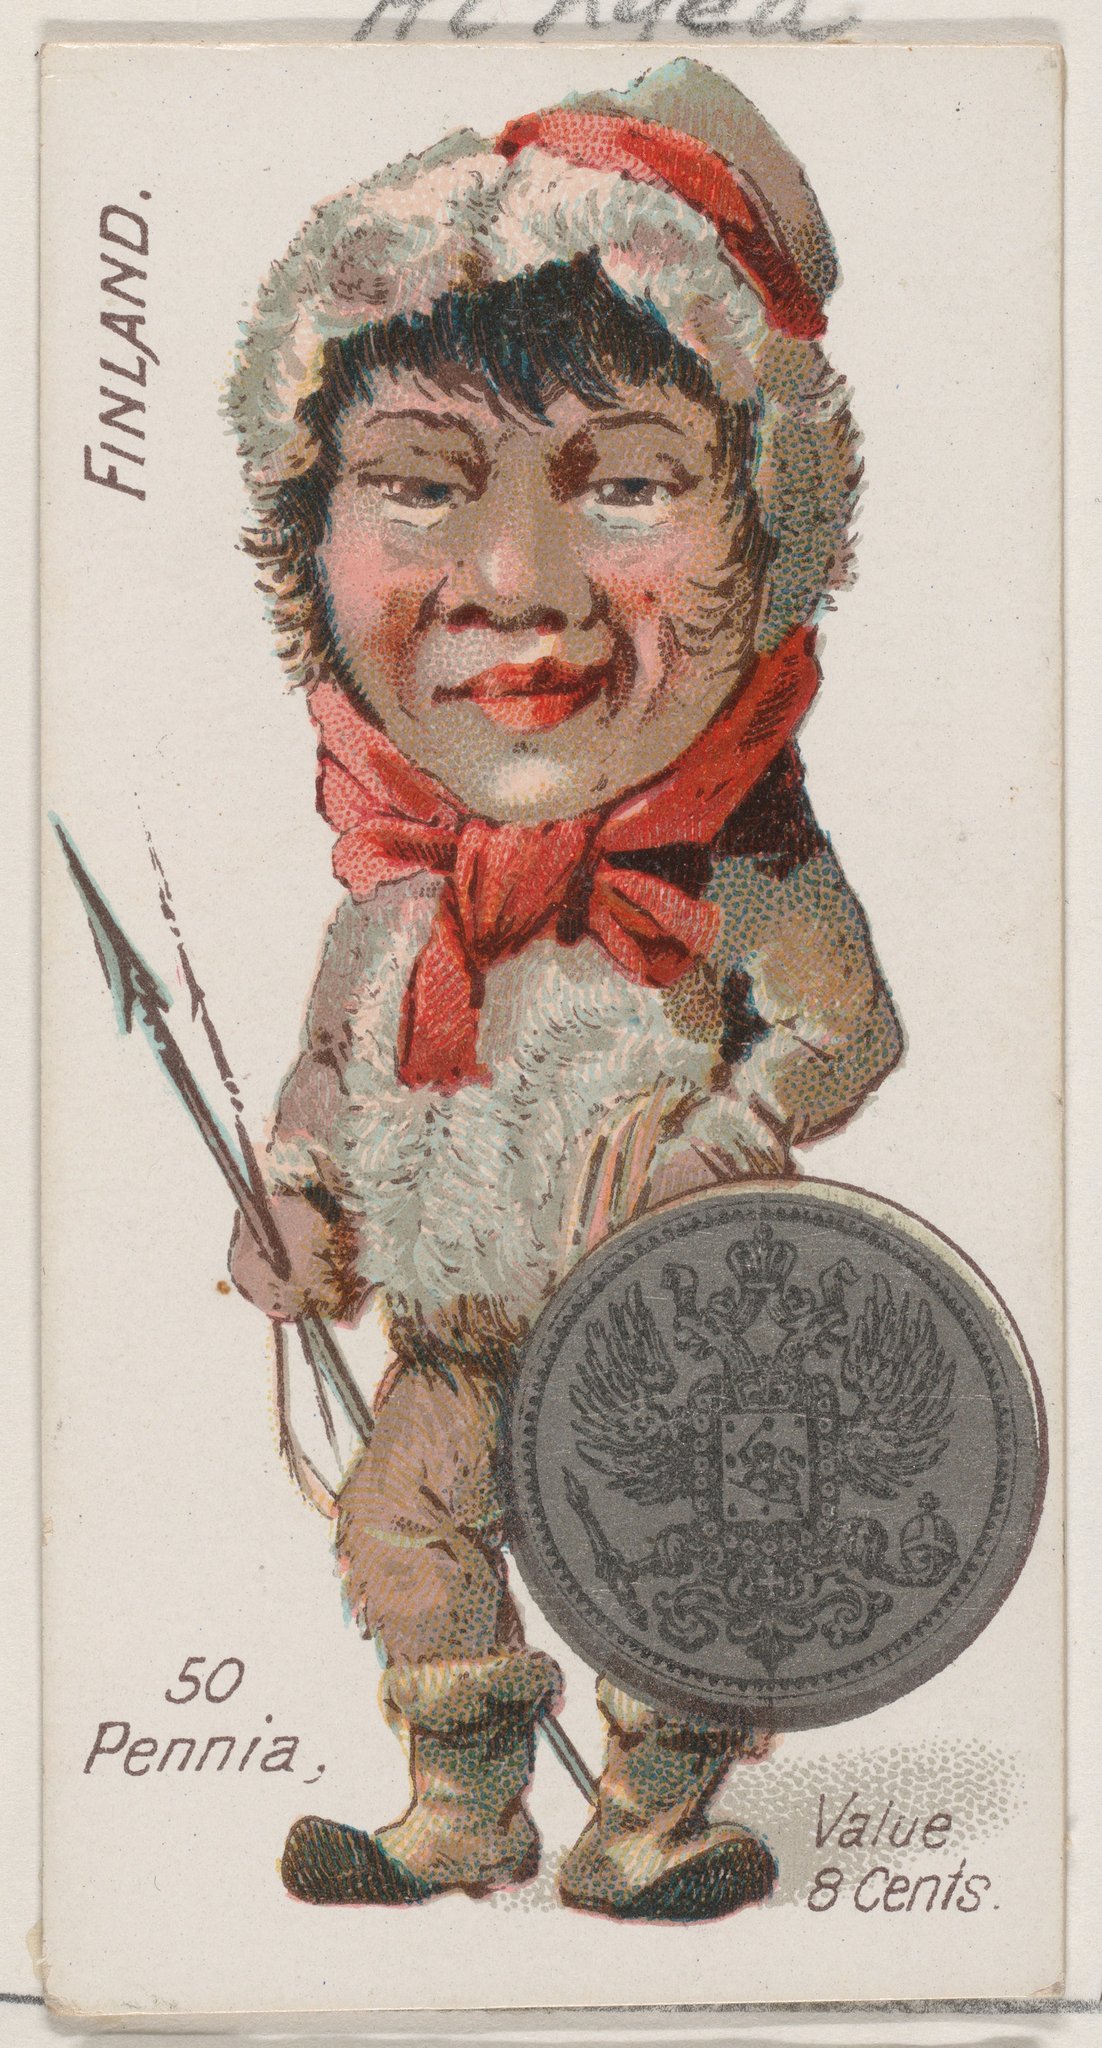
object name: print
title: Finland, 50 Pennia, from the series Coins of All Nations (N72, variation 1) for Duke brand cigarettes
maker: w. duke, sons & co.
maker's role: publisher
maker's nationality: american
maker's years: 1870-1920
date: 1889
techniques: color lithograph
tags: coins